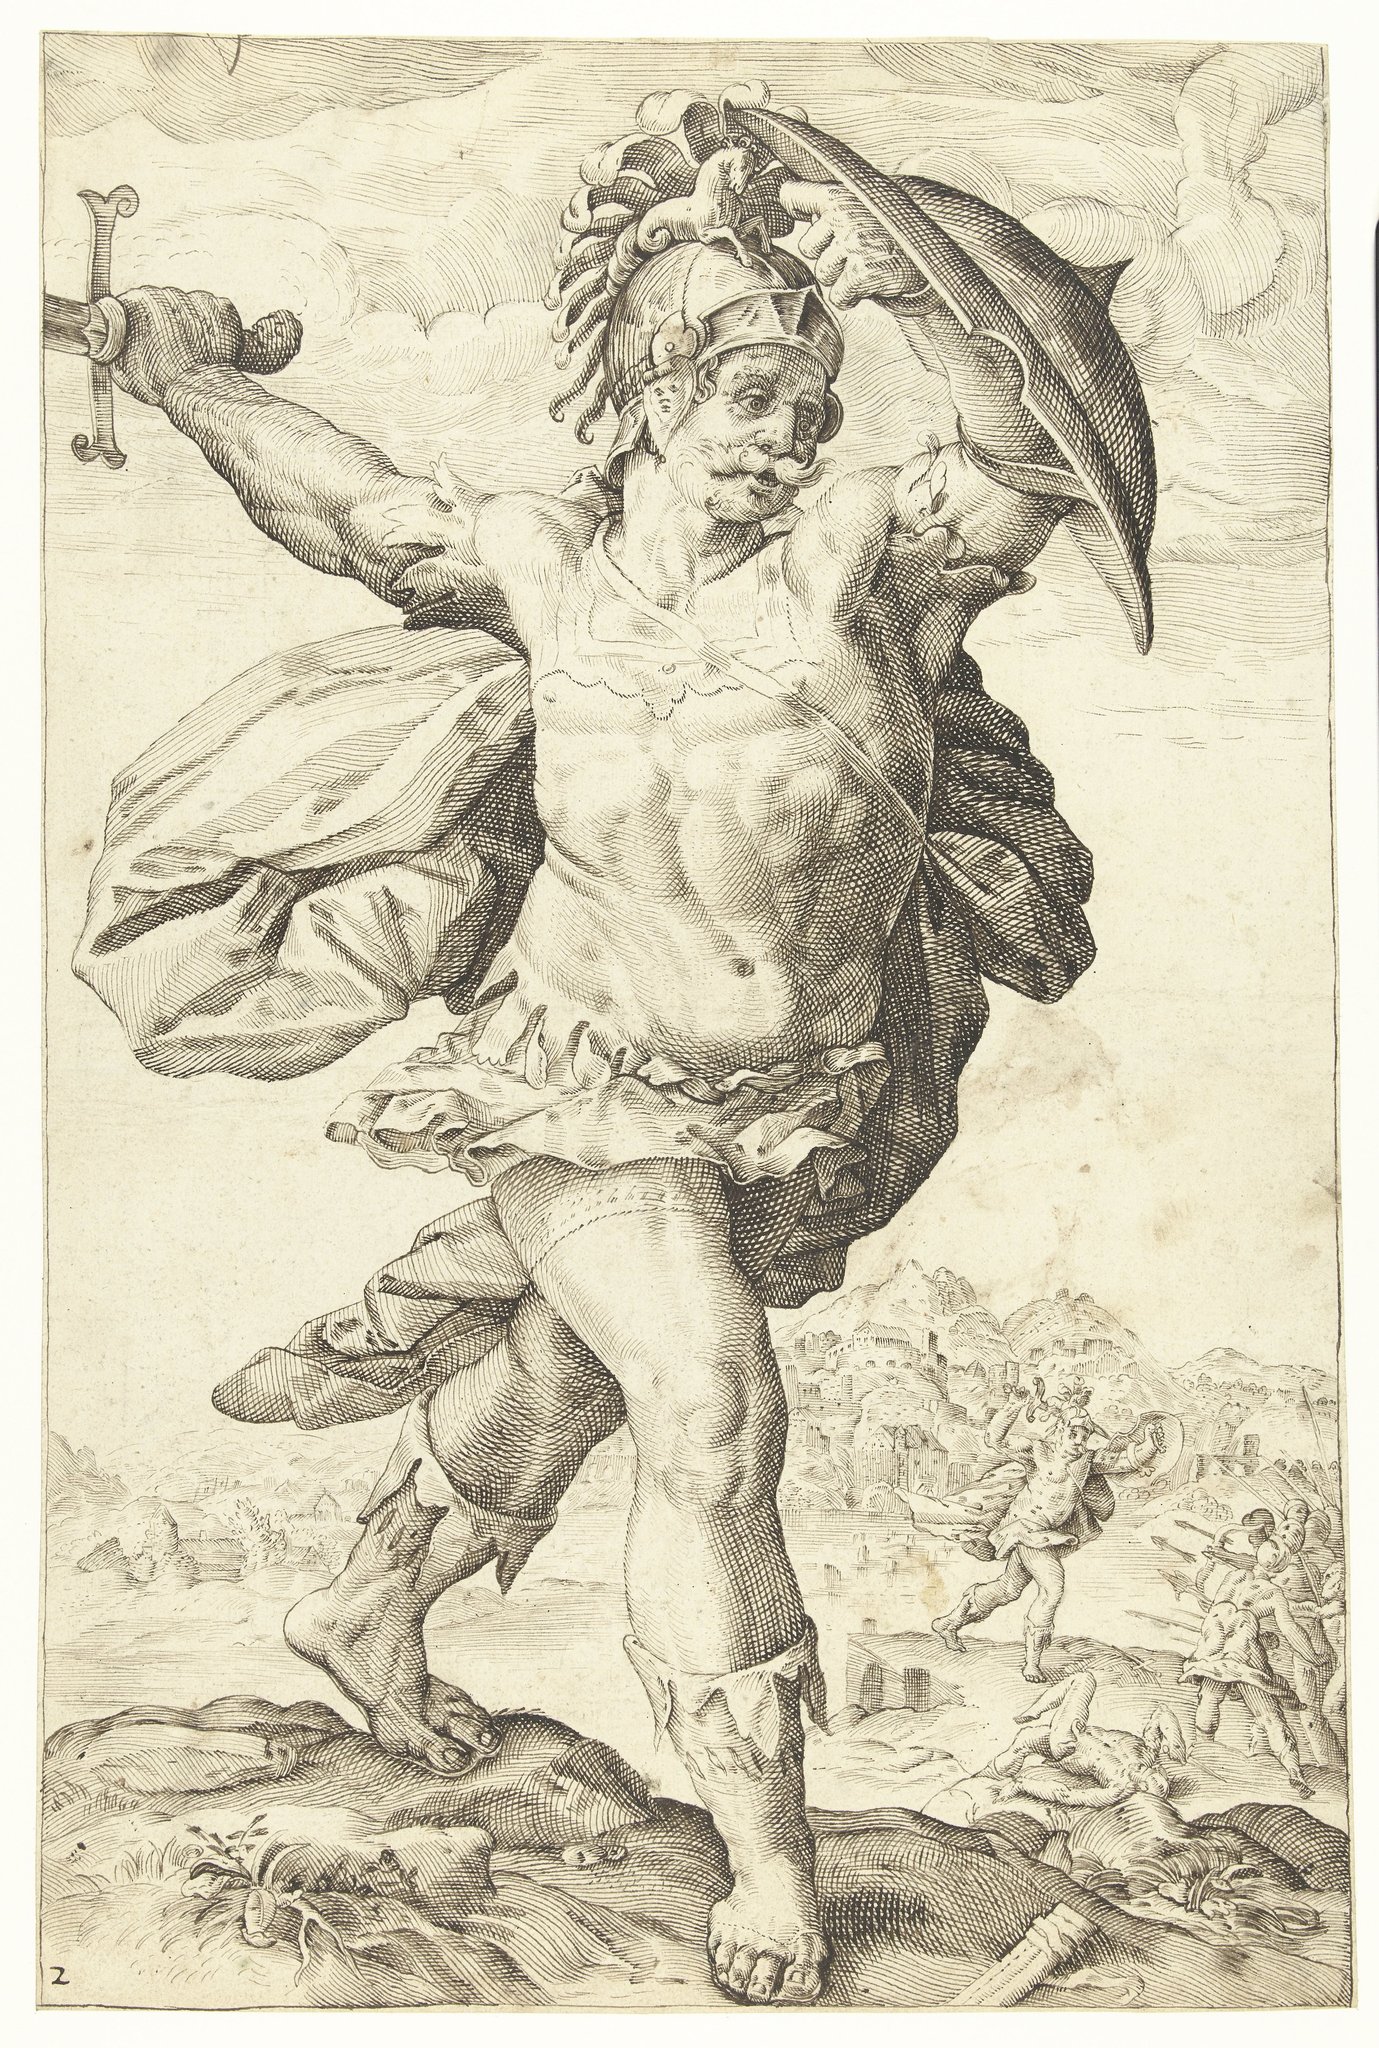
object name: drawing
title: Horatius Cocles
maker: lucas van haelwech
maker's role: draughtsman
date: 1602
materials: ink, paper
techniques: pen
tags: horatius cocles at the pons sublicius: single-handed he keeps the etruscans at bay while the bridge is broken down by the romans behind him; he escapes by jumping into the tiber